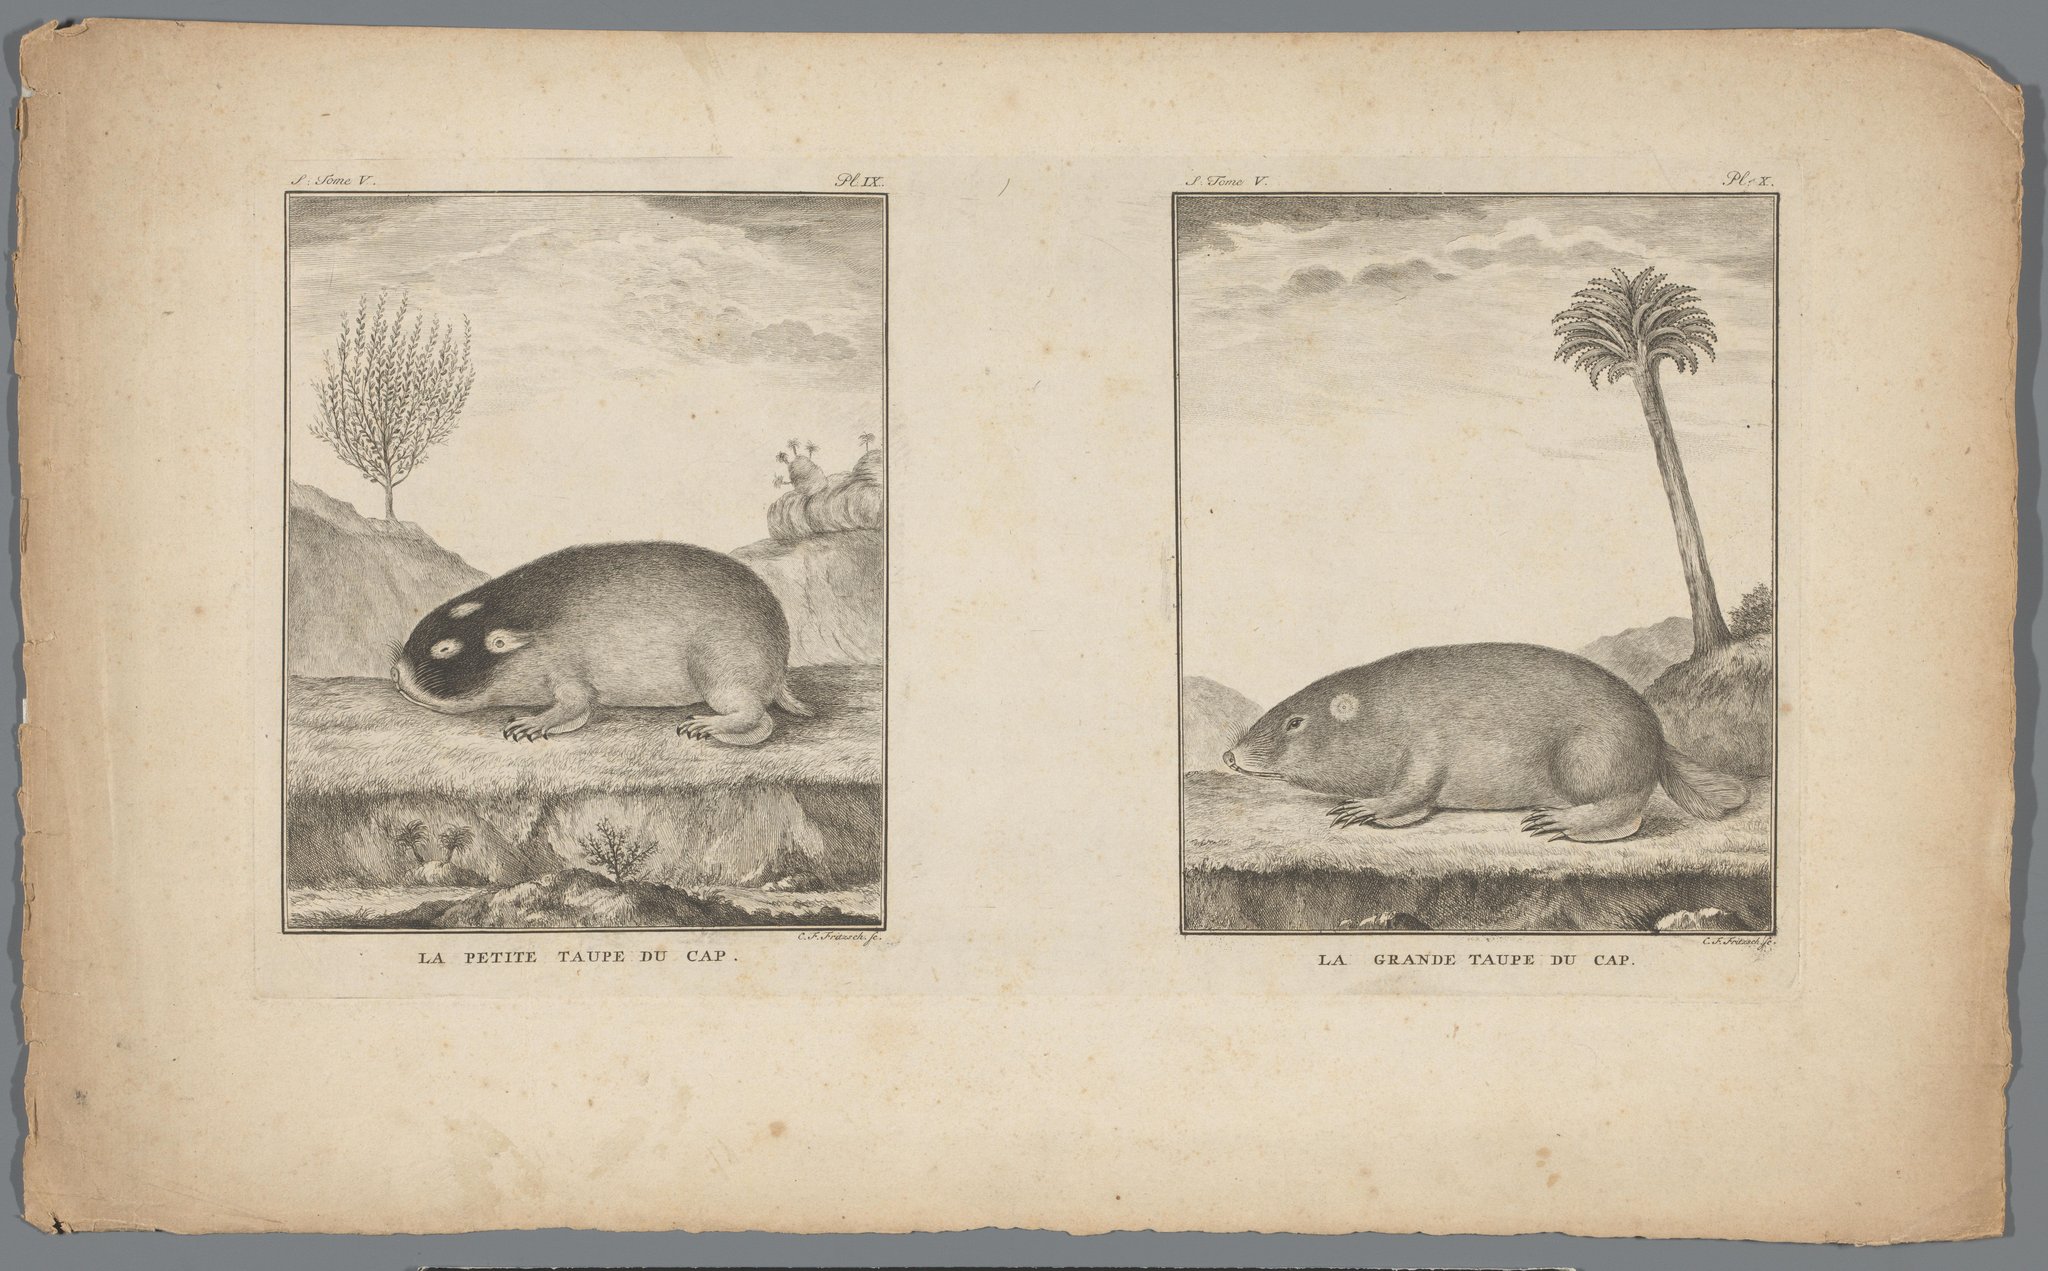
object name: print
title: La Petite Taupe du Cap / La Grande Taupe du Cap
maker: christian friedrich fritzsch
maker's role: print maker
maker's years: 1719-1774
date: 1781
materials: paper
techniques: engraving, etching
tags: other mammals: mole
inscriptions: label: ‘B5’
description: Gebruikt als boekillustratie in: van G.L. Leclerc de Buffon en L.J.M. Daubenton, bewerkt door J.N.S. Allamand, Histoire Naturelle (Nouvelle Edition bewerkt door J.N.S. Allamand), Amsterdam: J.H. Schneider, 1766-1799, supplement V (1781).